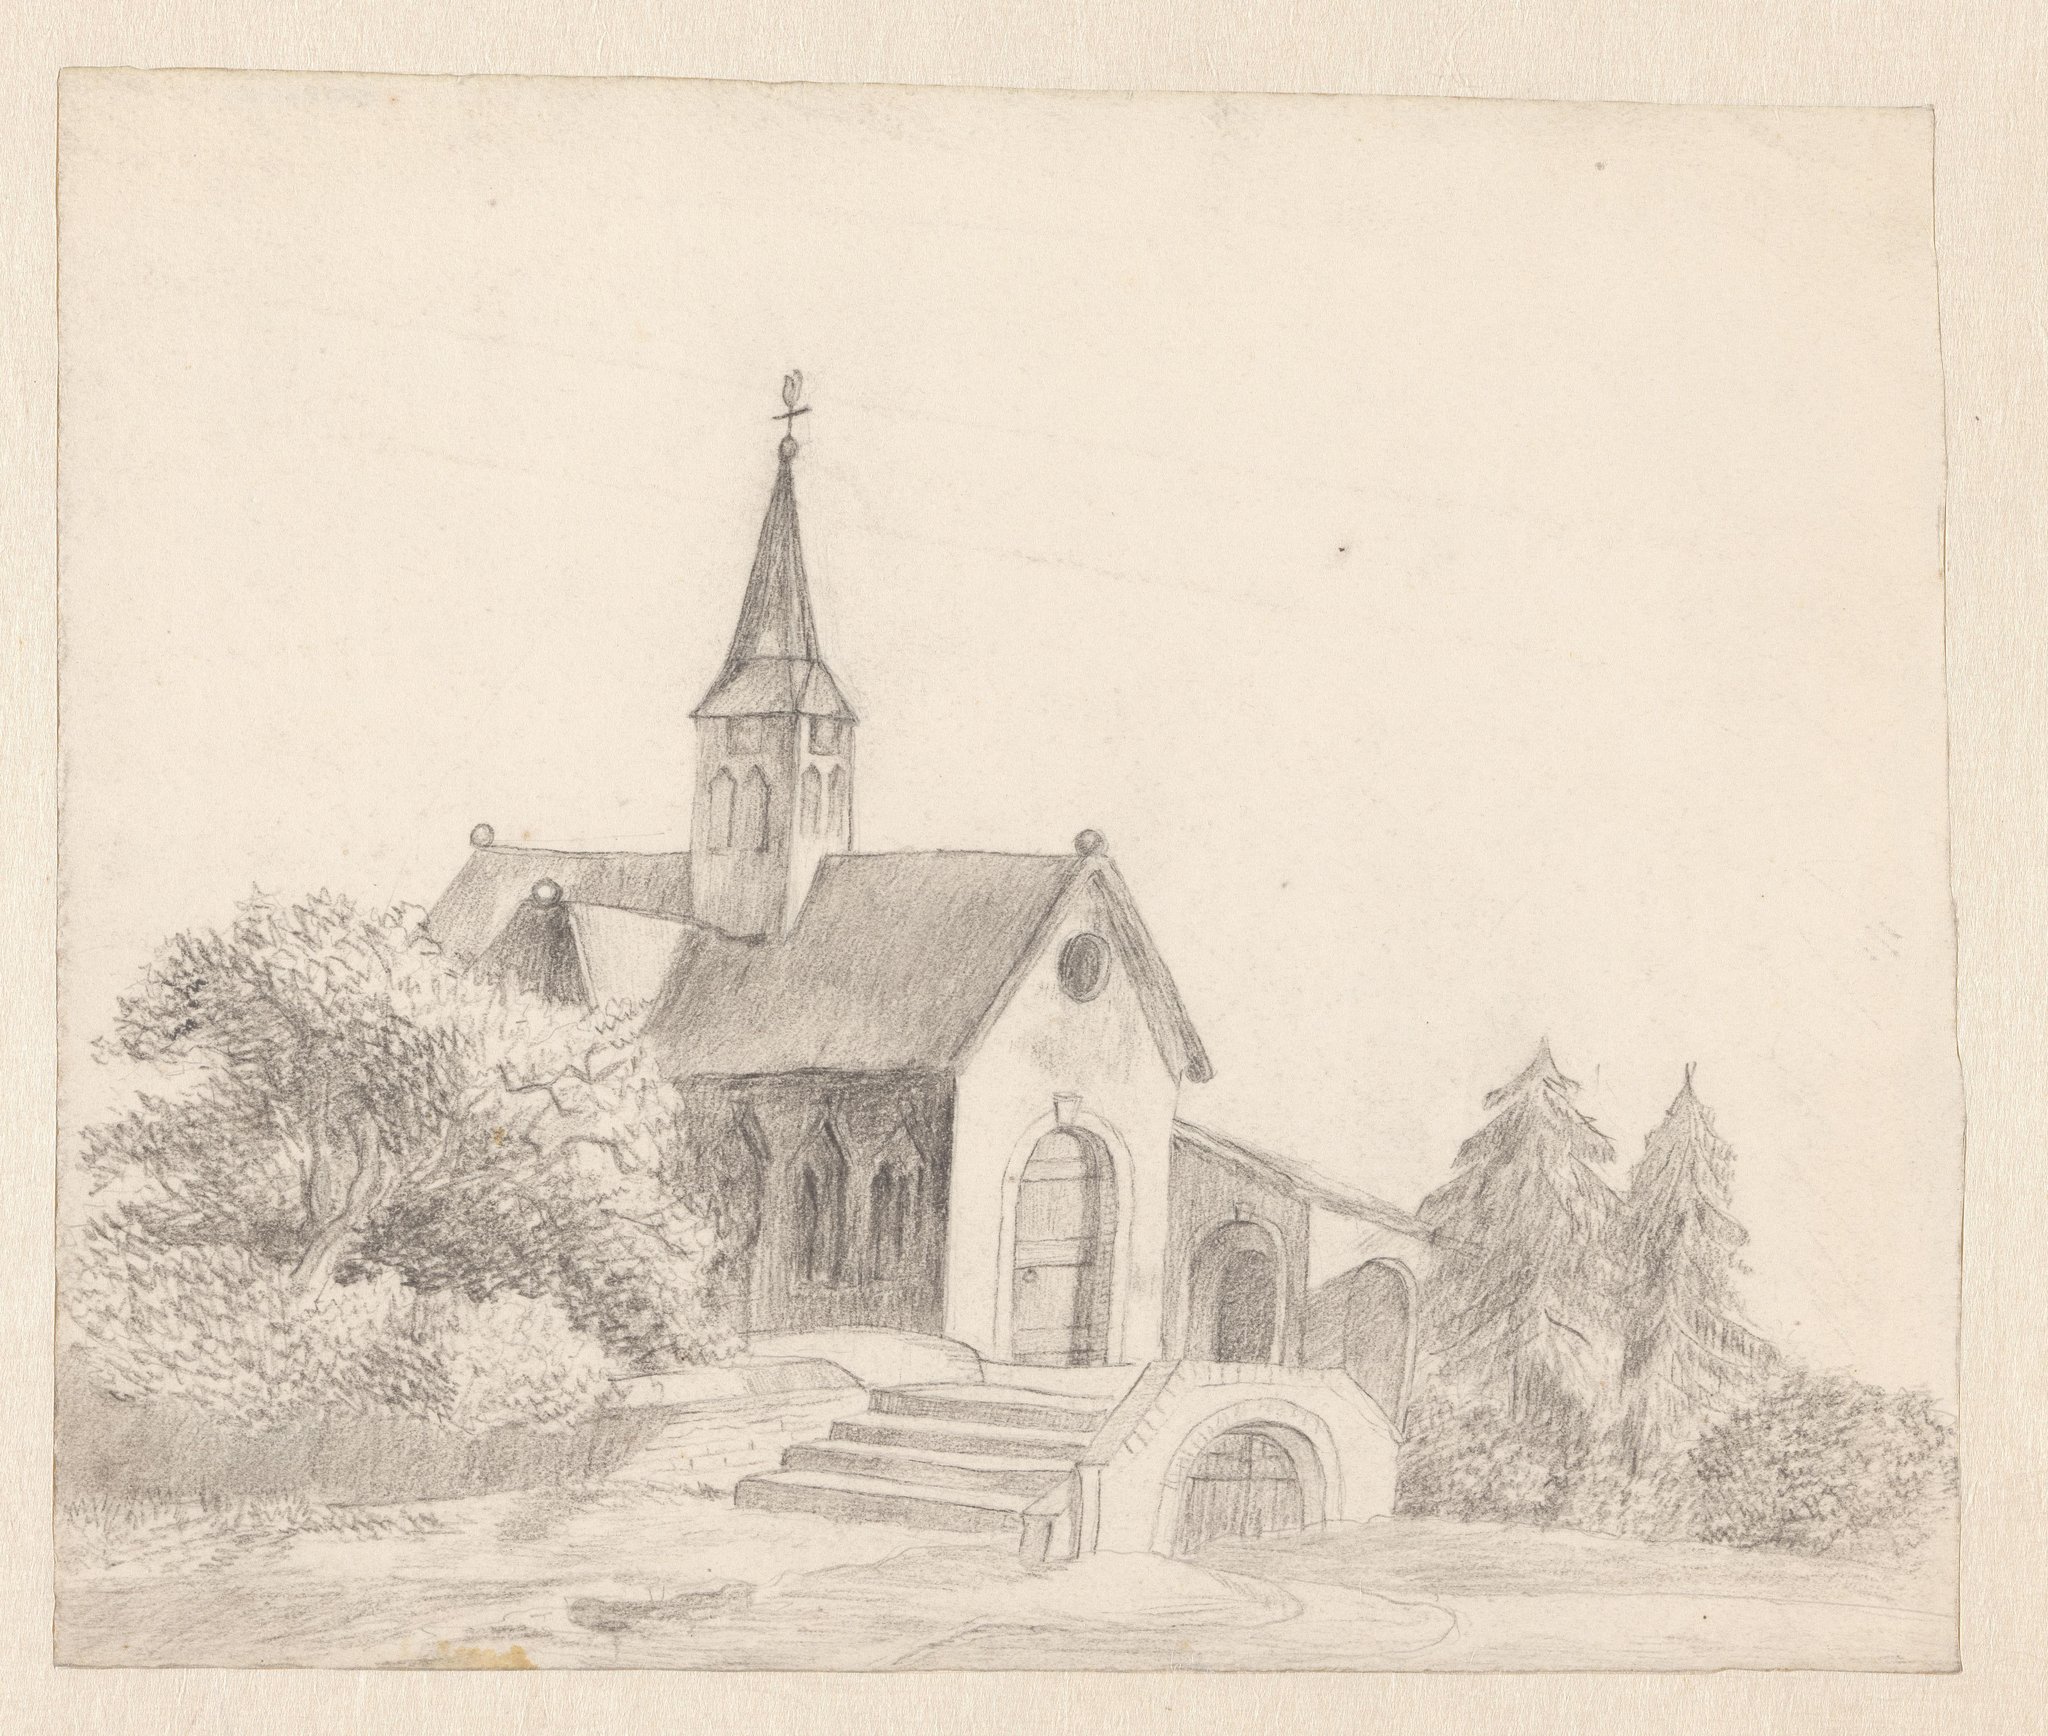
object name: drawing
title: Kerkgebouw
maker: joannes carolus alberdingk thijm (jan)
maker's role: pater, schrijver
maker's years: 1847-1926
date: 1853-1860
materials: chalk, paper, pencil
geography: netherlands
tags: church (exterior)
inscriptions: inscription: ‘A.Th.’